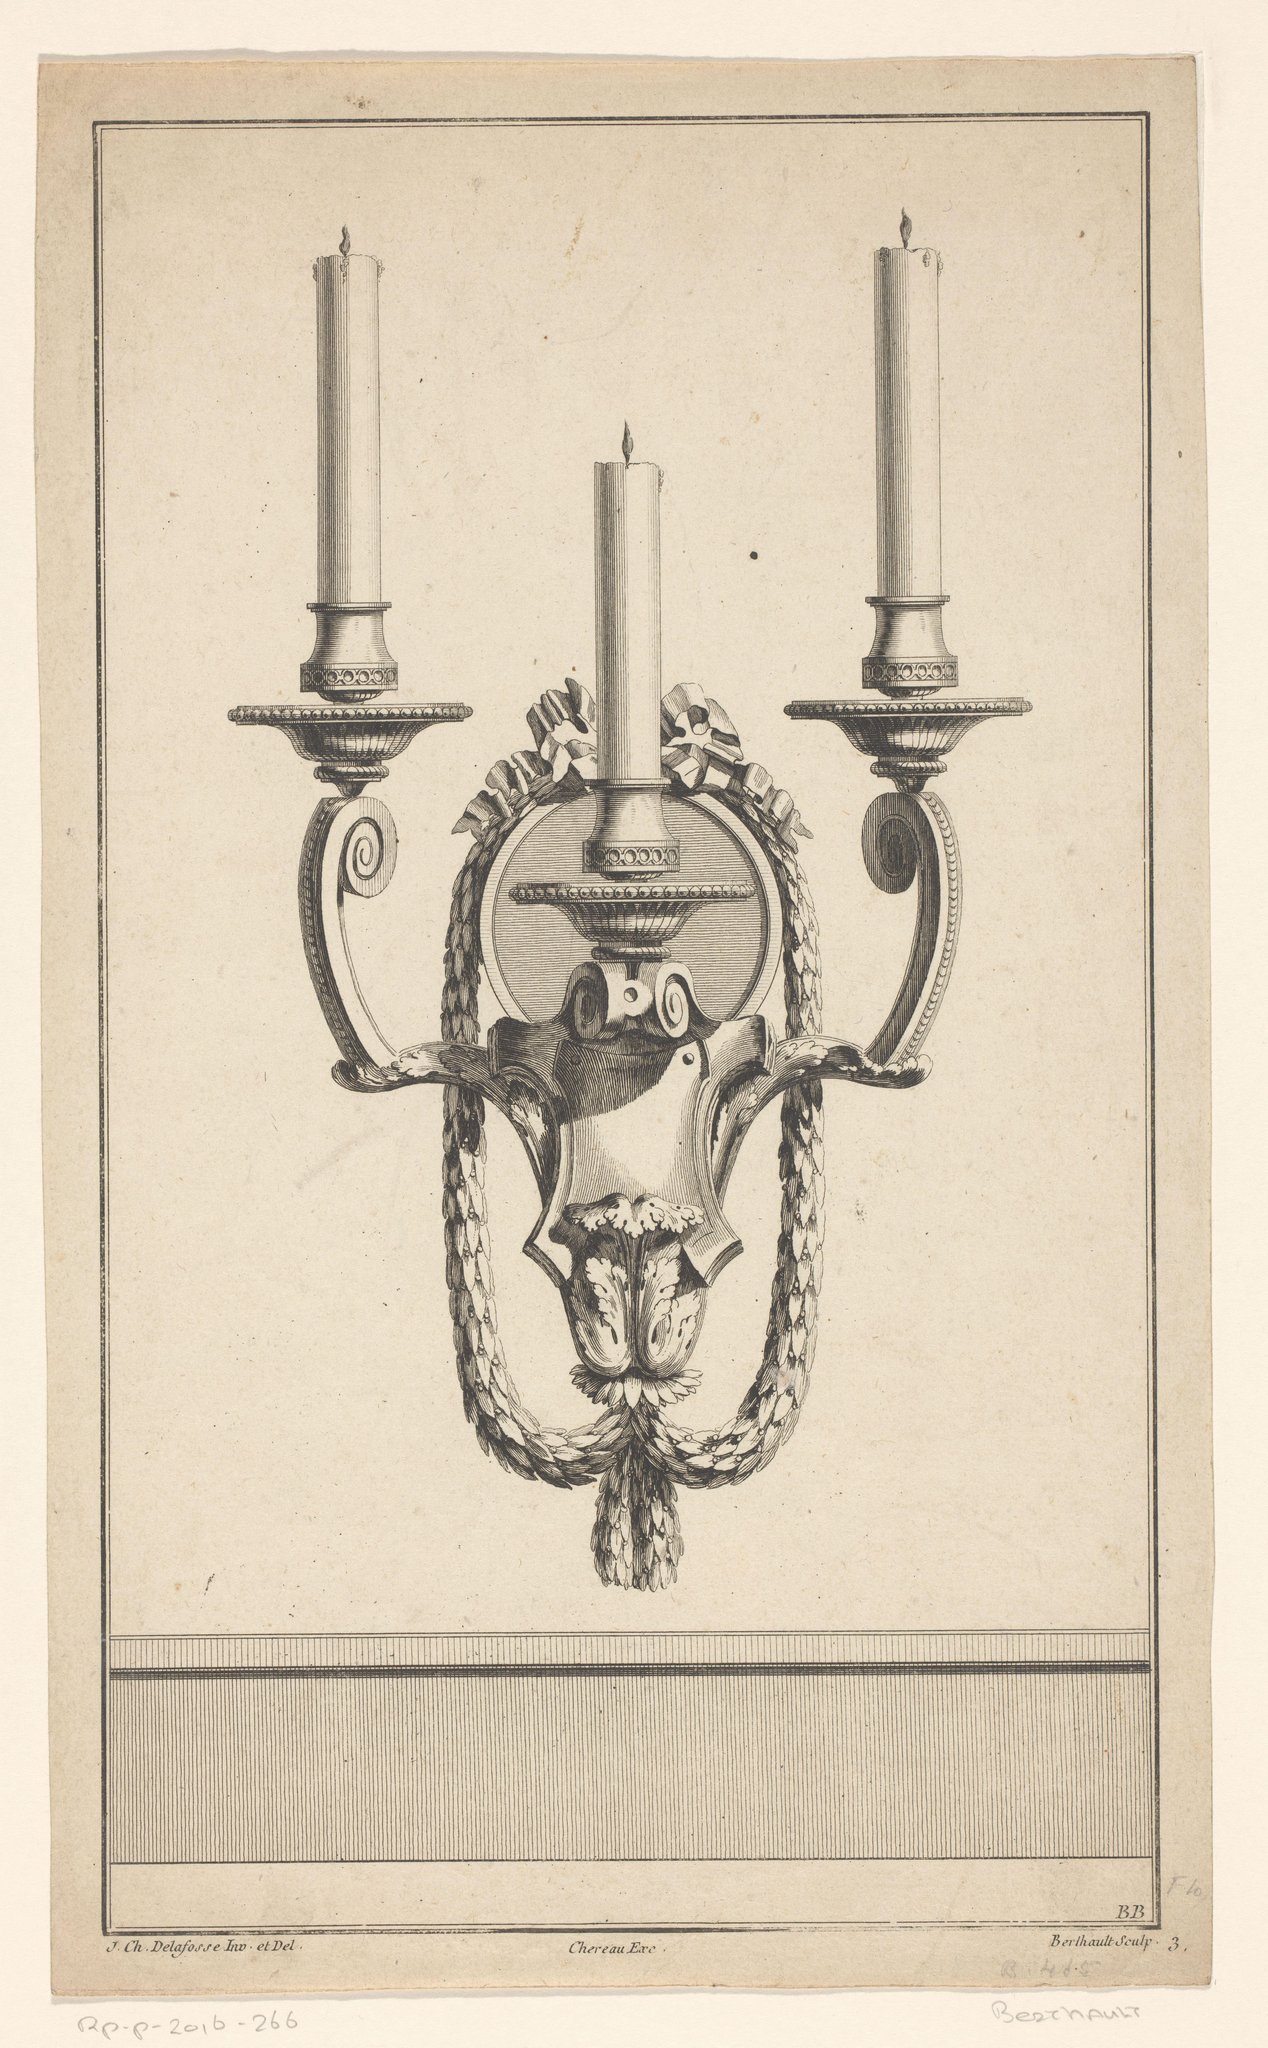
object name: ornament print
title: IIe Volume De l'Oeuvre de J. Ch. Delafosse (...)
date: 1771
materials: paper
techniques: engraving, etching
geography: paris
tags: chandelier, candelabrum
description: Een geornamenteerde driearmige girandole met guirlandes